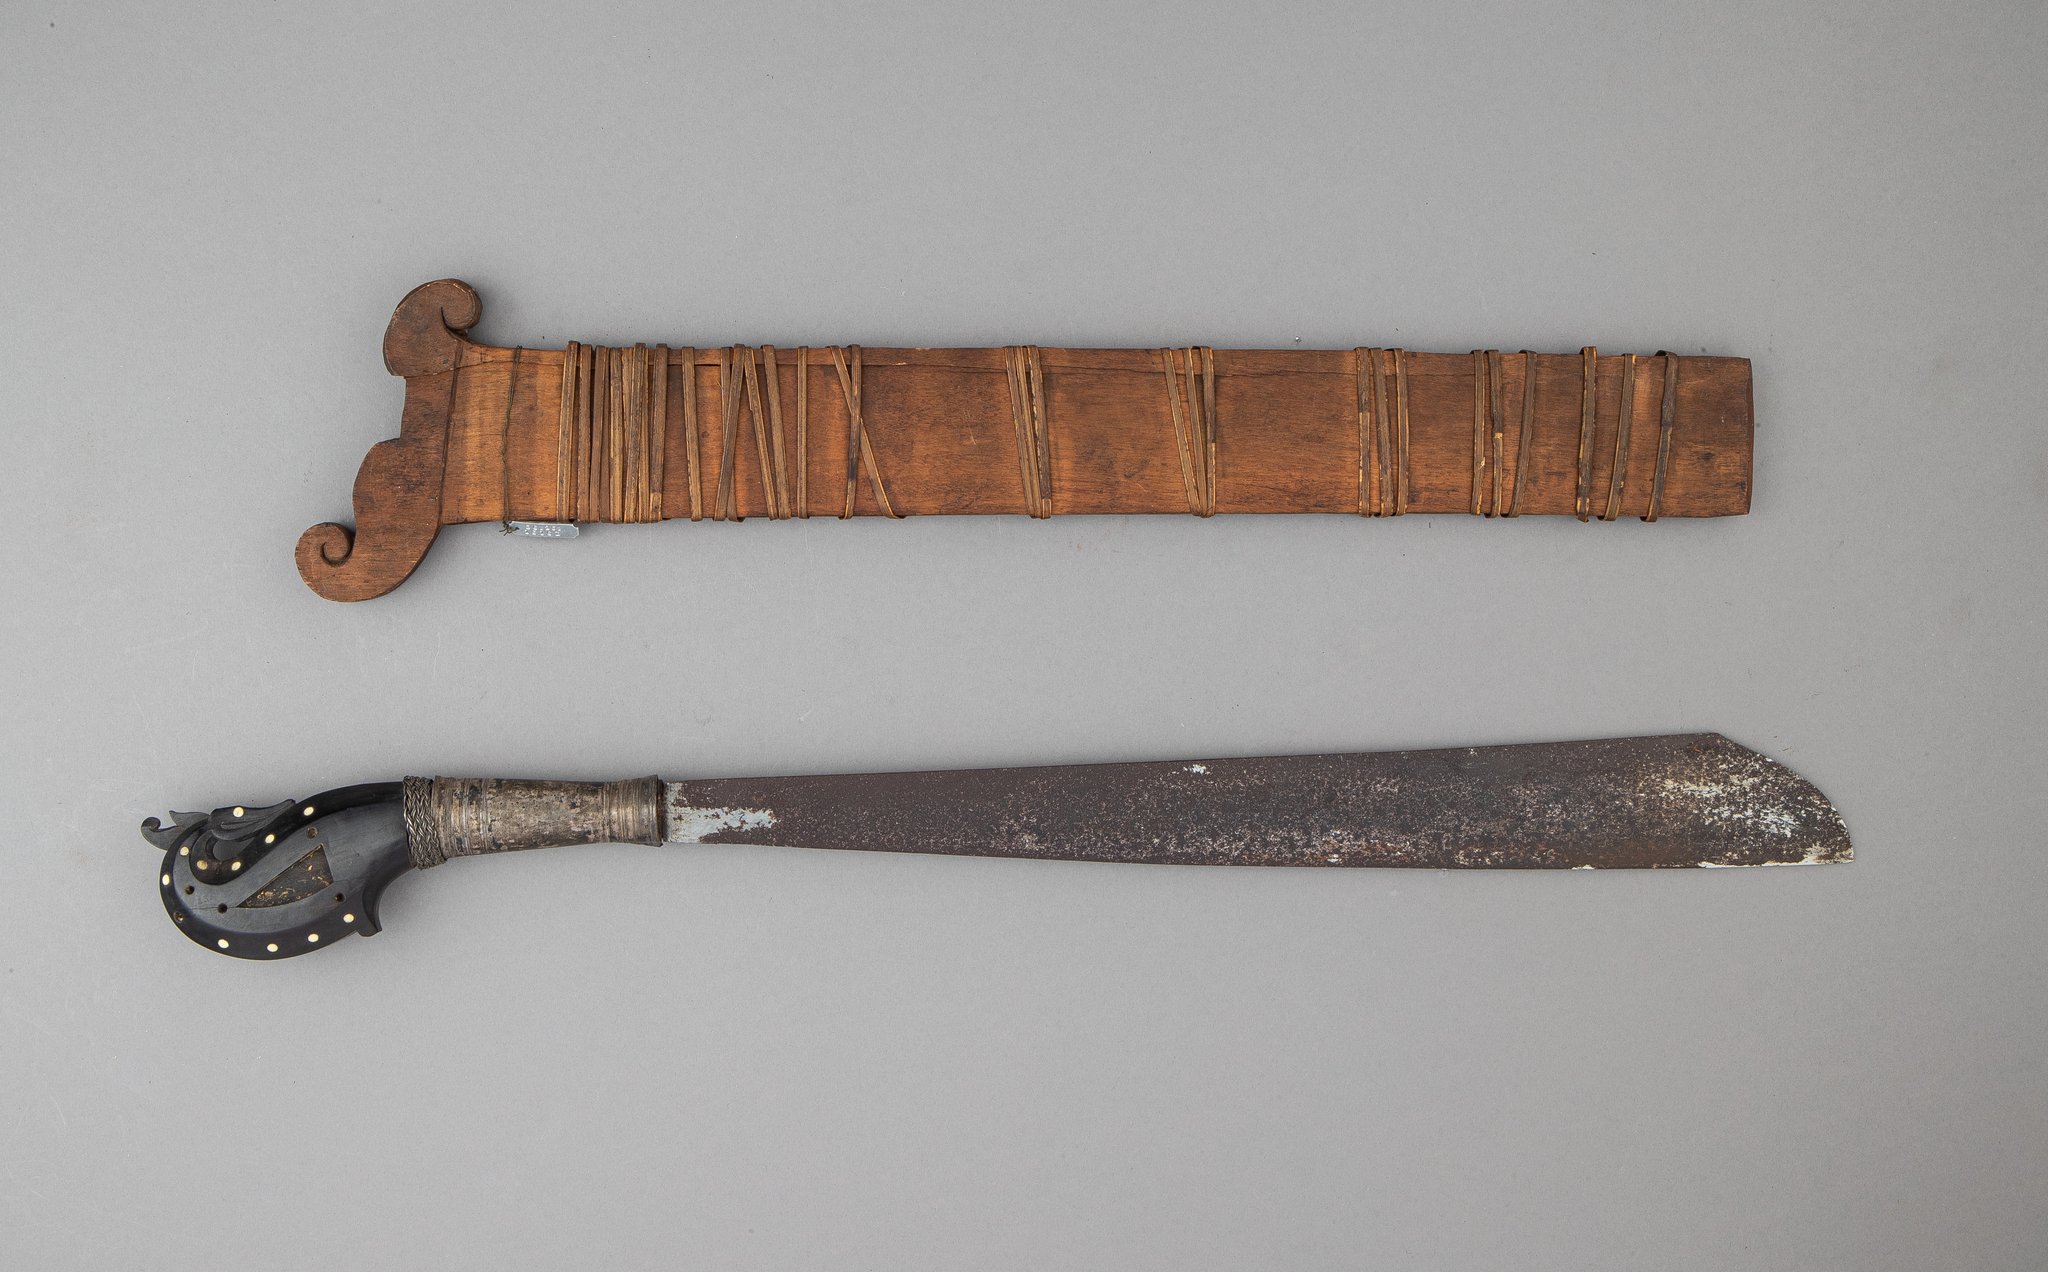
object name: sword klewang with scabbard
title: Sword (Klewang) with Scabbard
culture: malayan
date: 1701-1900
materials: bone, silver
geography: malaysia